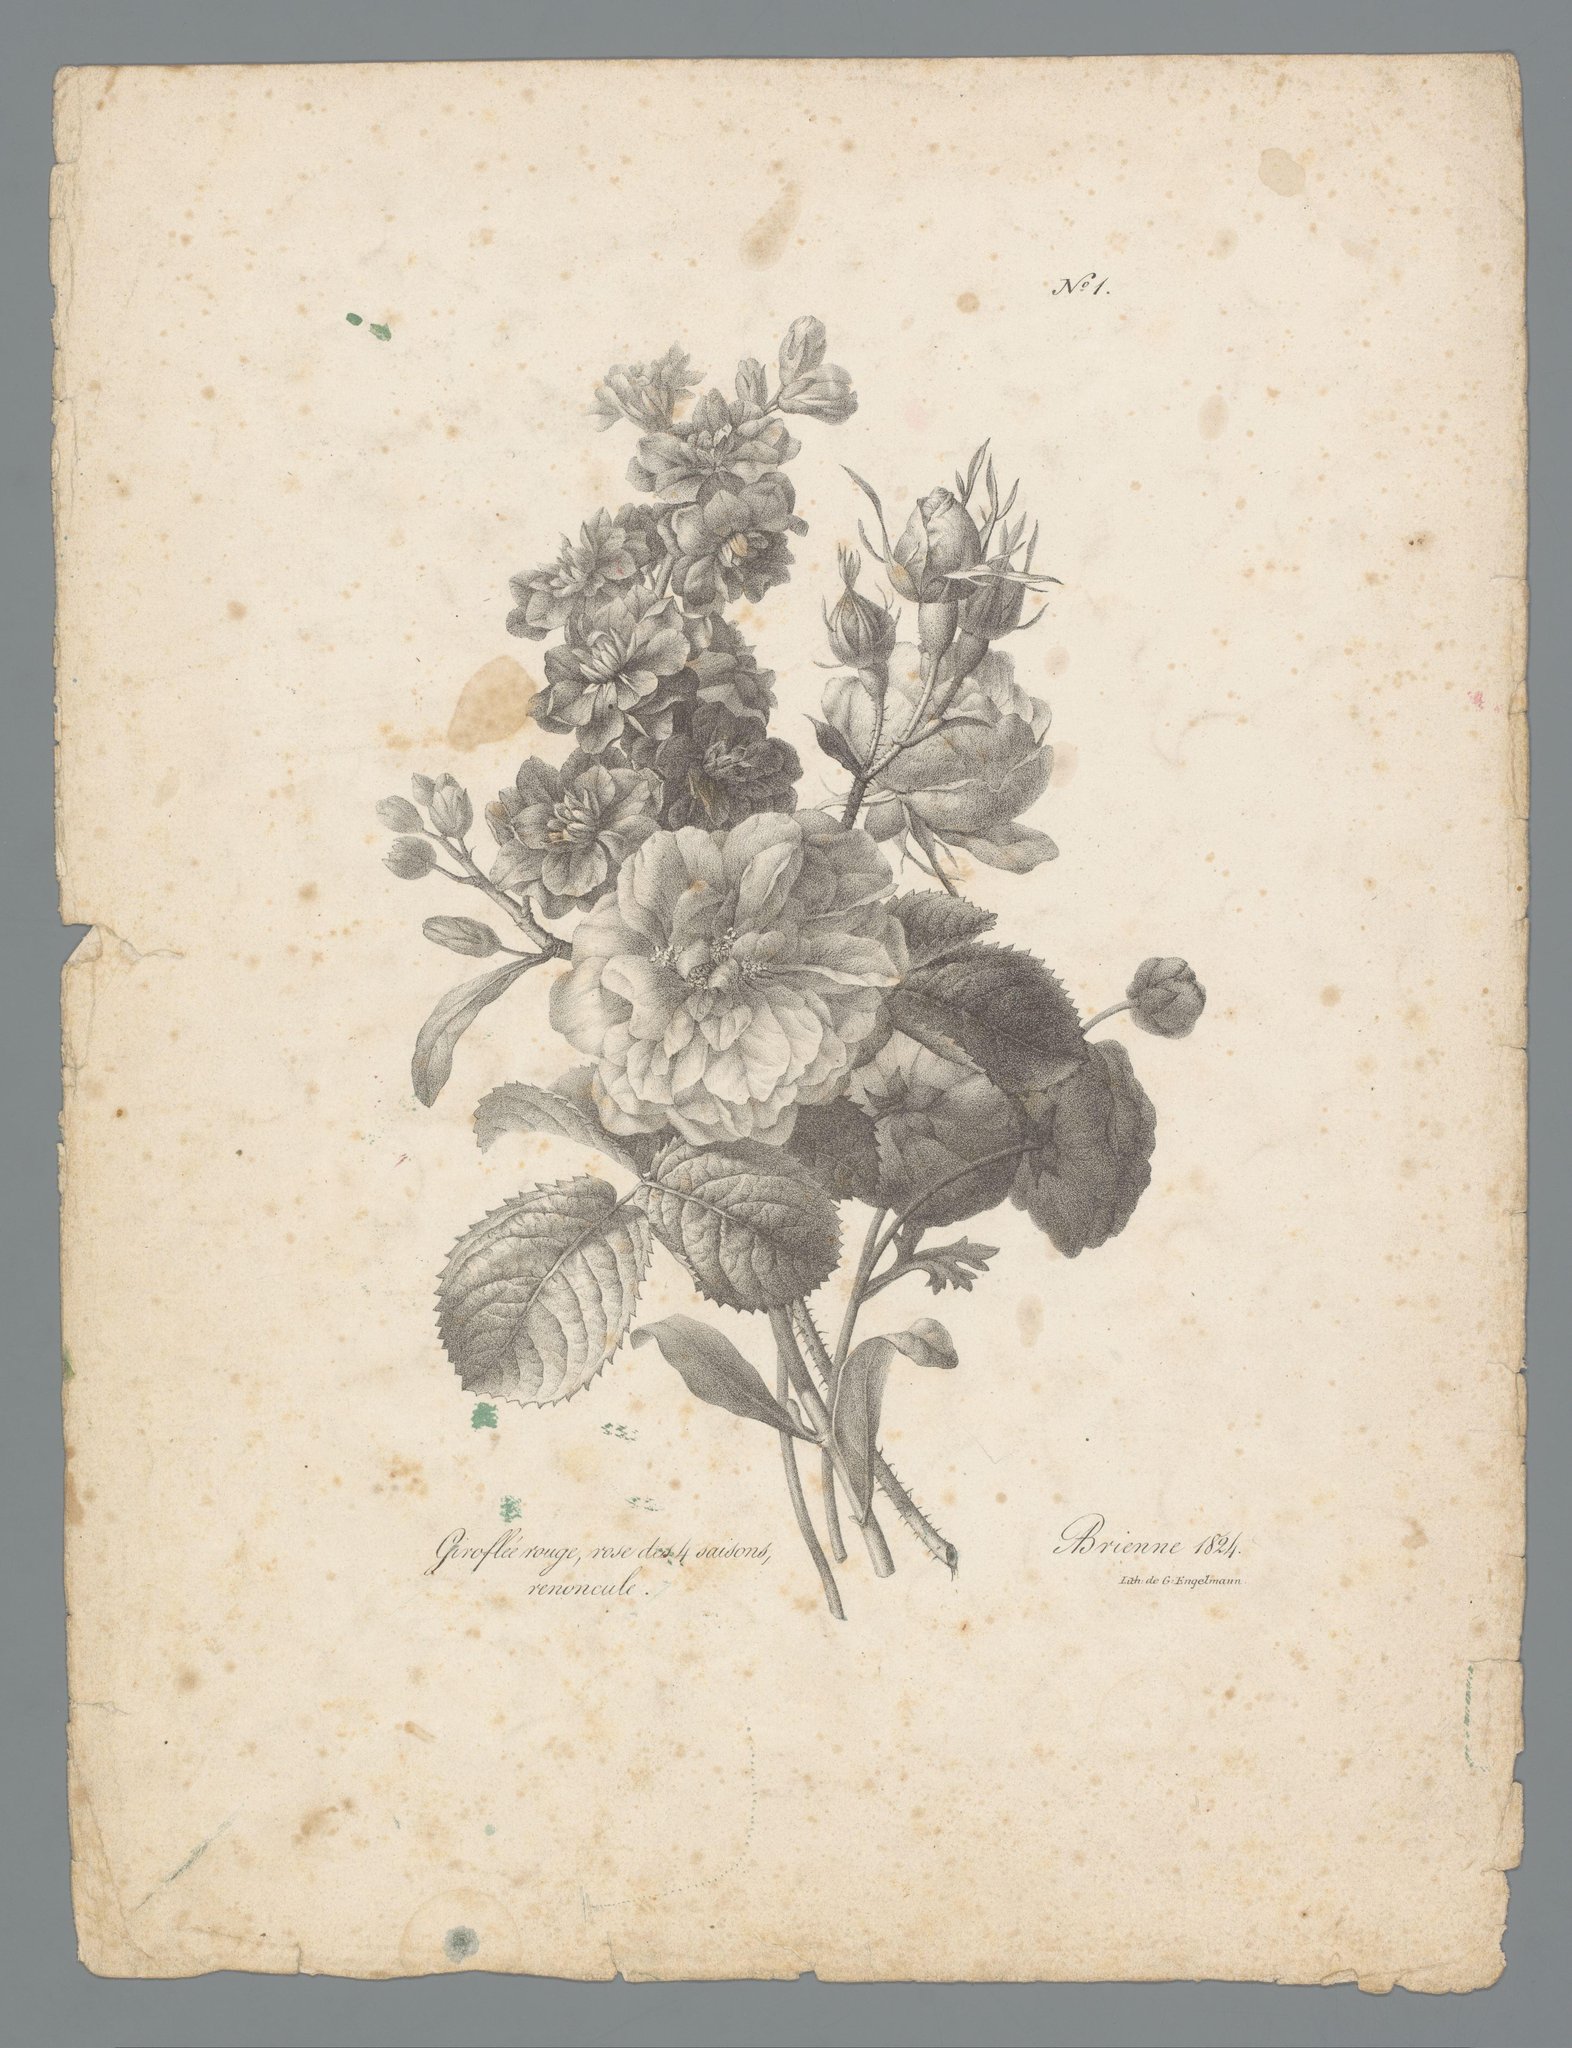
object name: print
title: Giroflée rouge, rose des 4 saisons, renoncule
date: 1824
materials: paper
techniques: lithograph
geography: paris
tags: cut flowers; nosegay, bunch of flowers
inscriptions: collector's mark: Lugt 2233